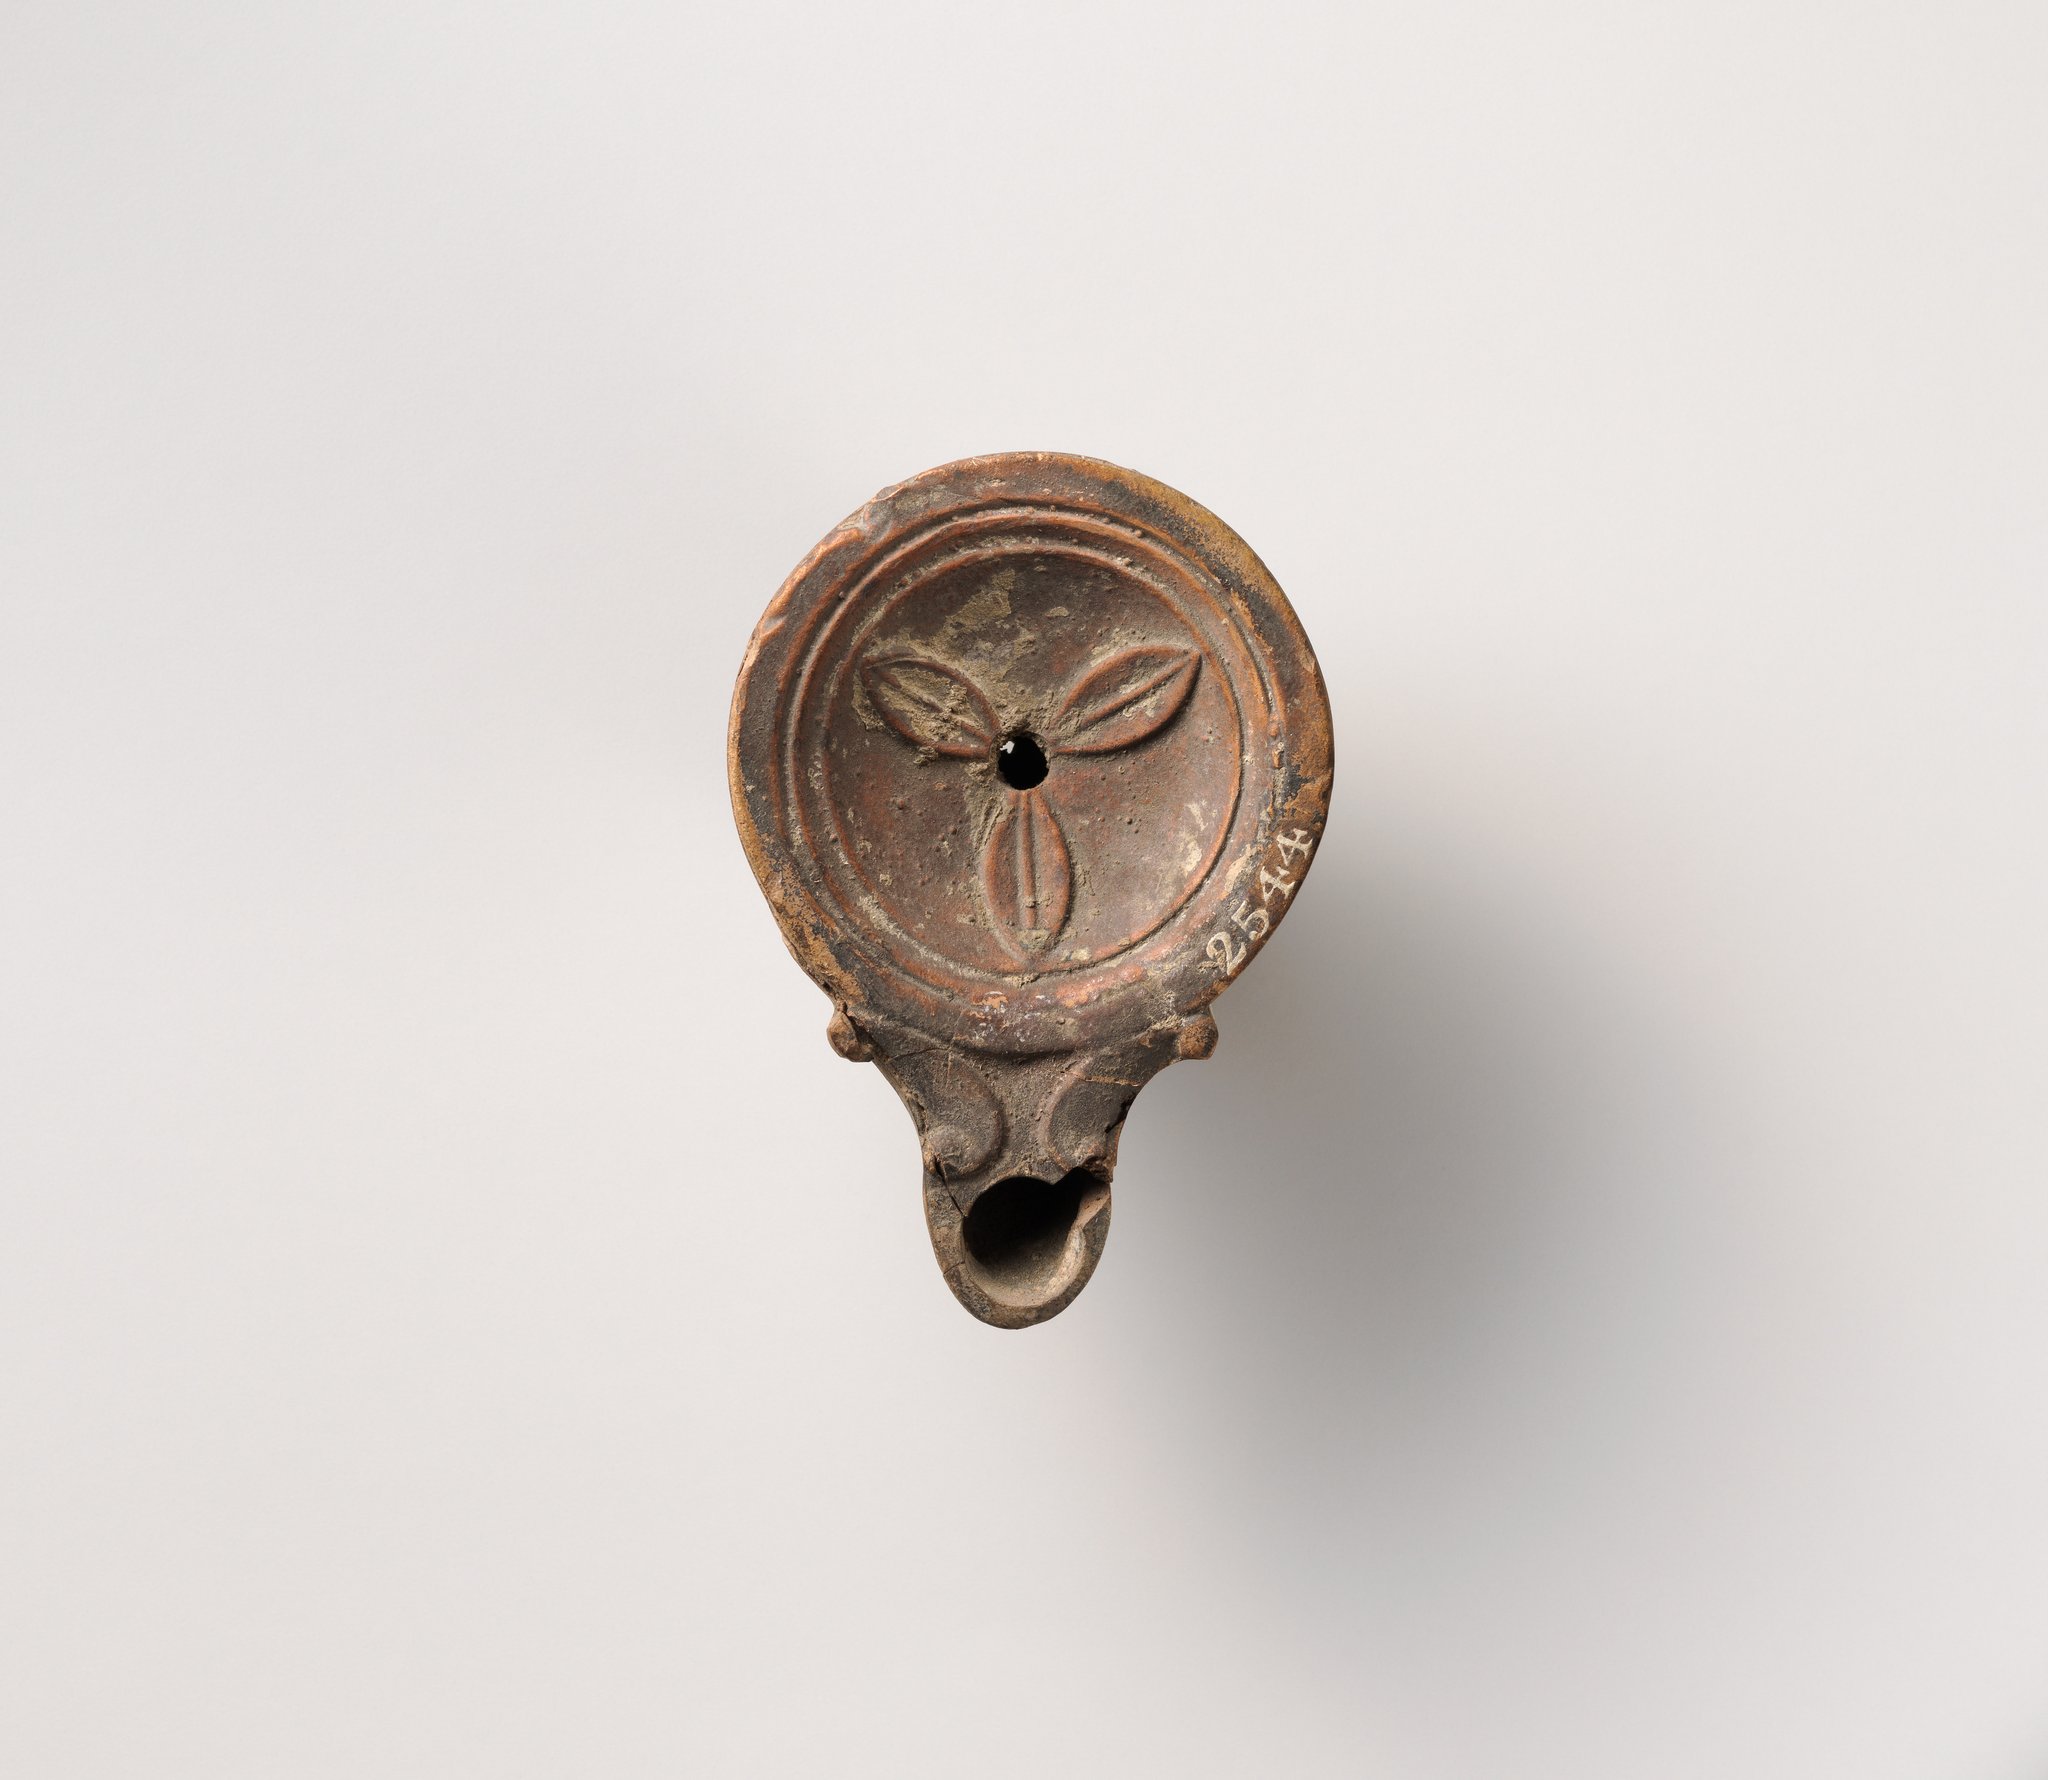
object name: lamp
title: Terracotta oil lamp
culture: roman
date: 40-100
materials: terracotta